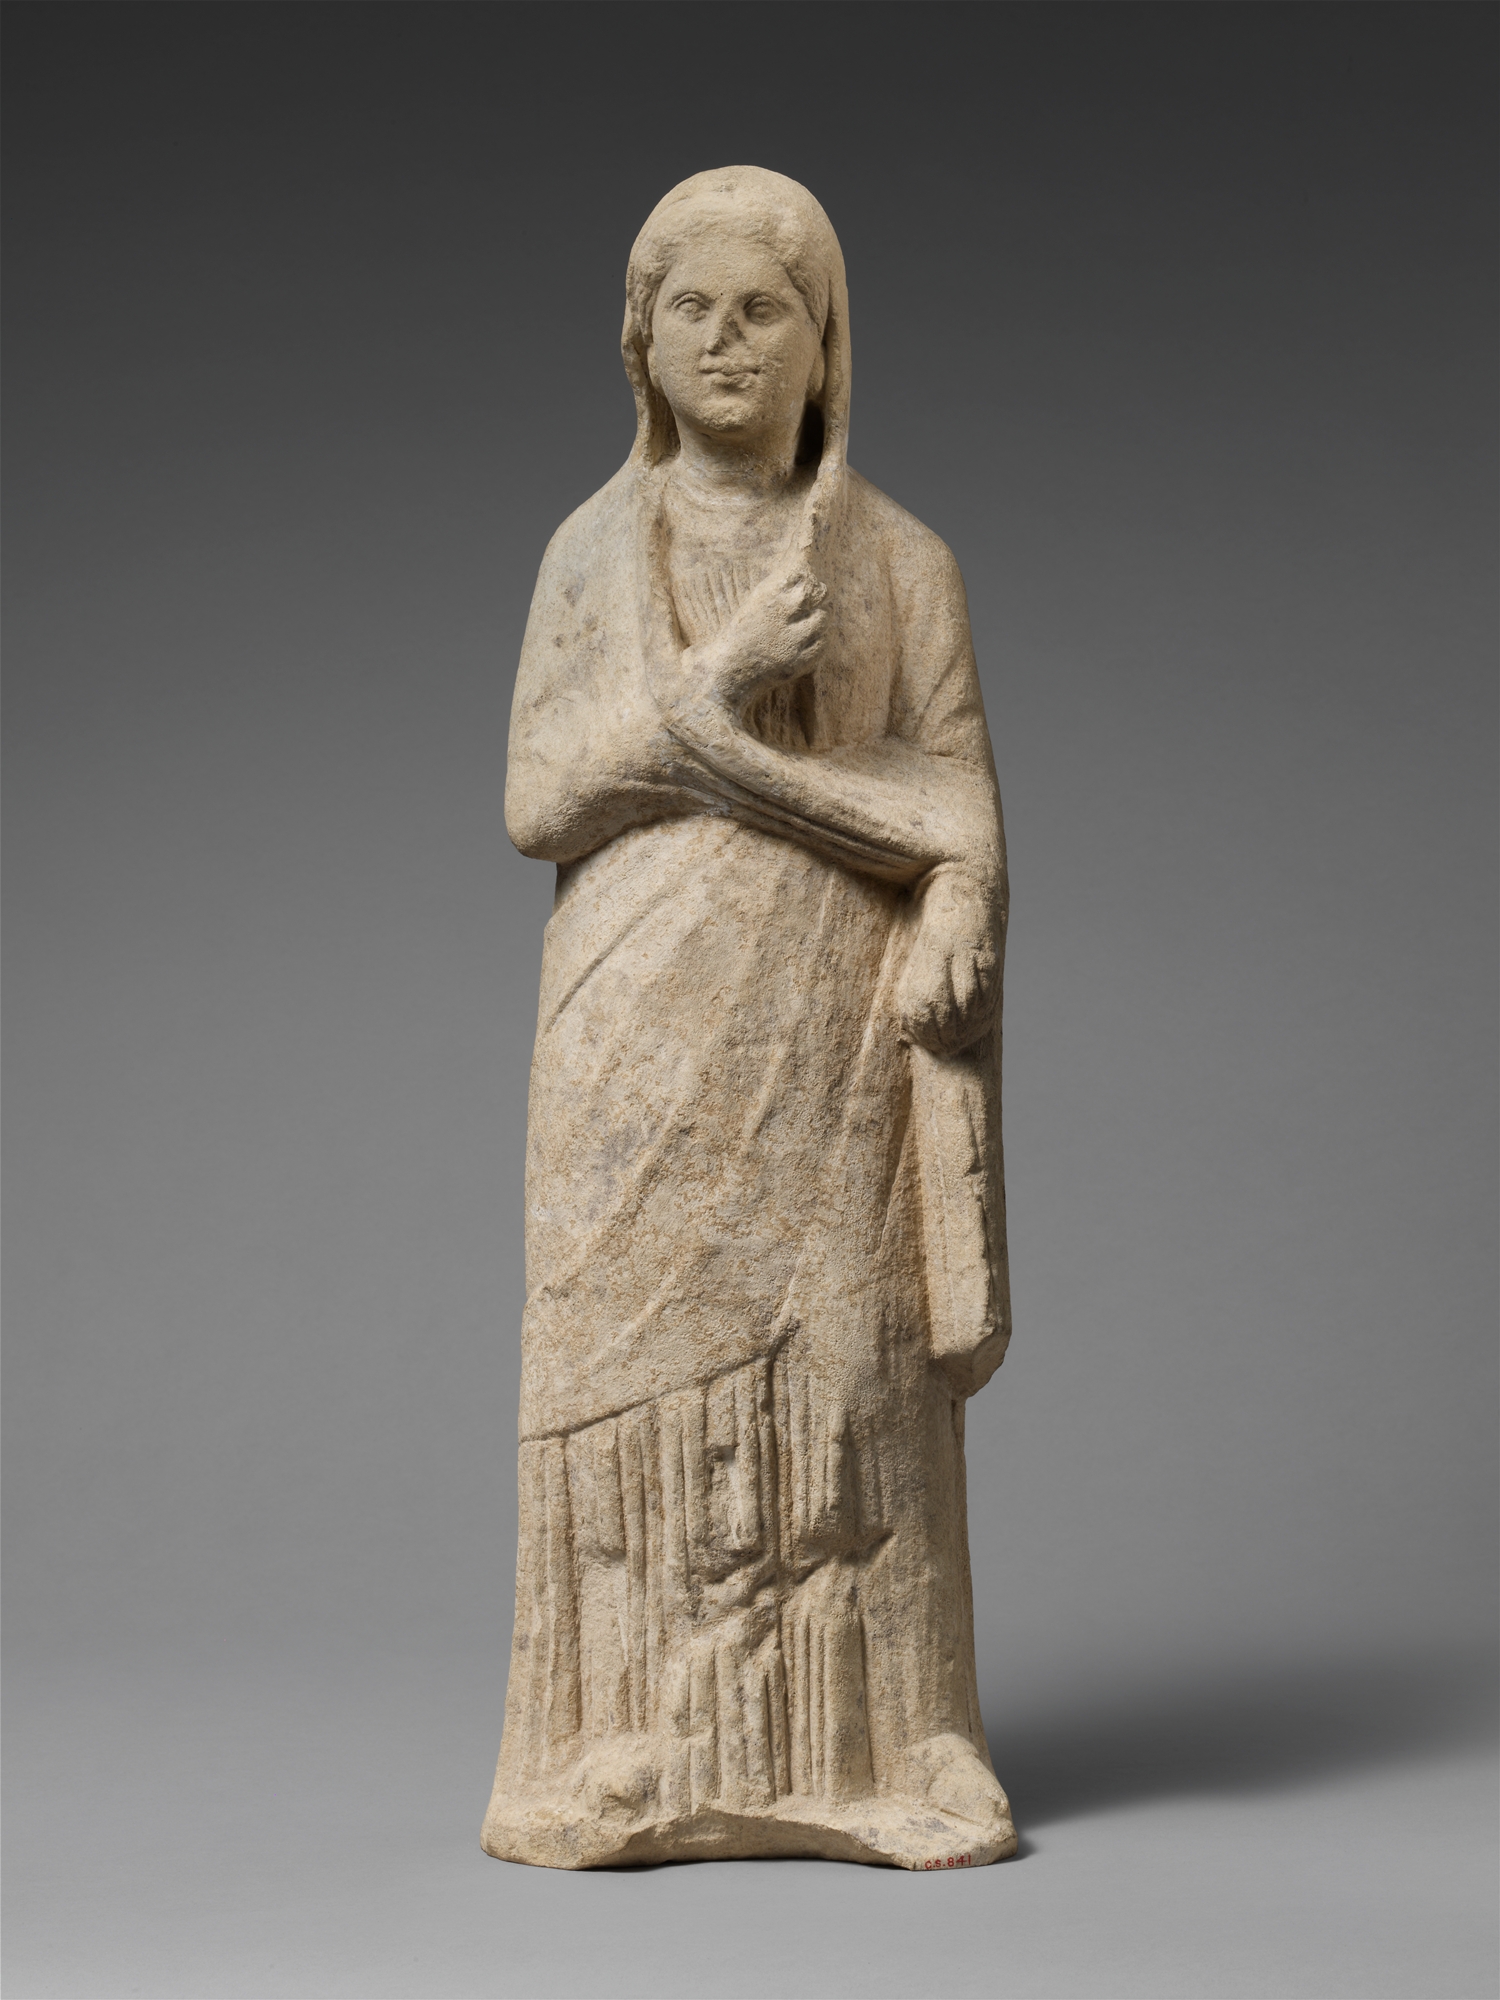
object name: statue of a votary, female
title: Limestone statuette of a female votary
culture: cypriot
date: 3900 BCE-100 CE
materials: limestone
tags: women